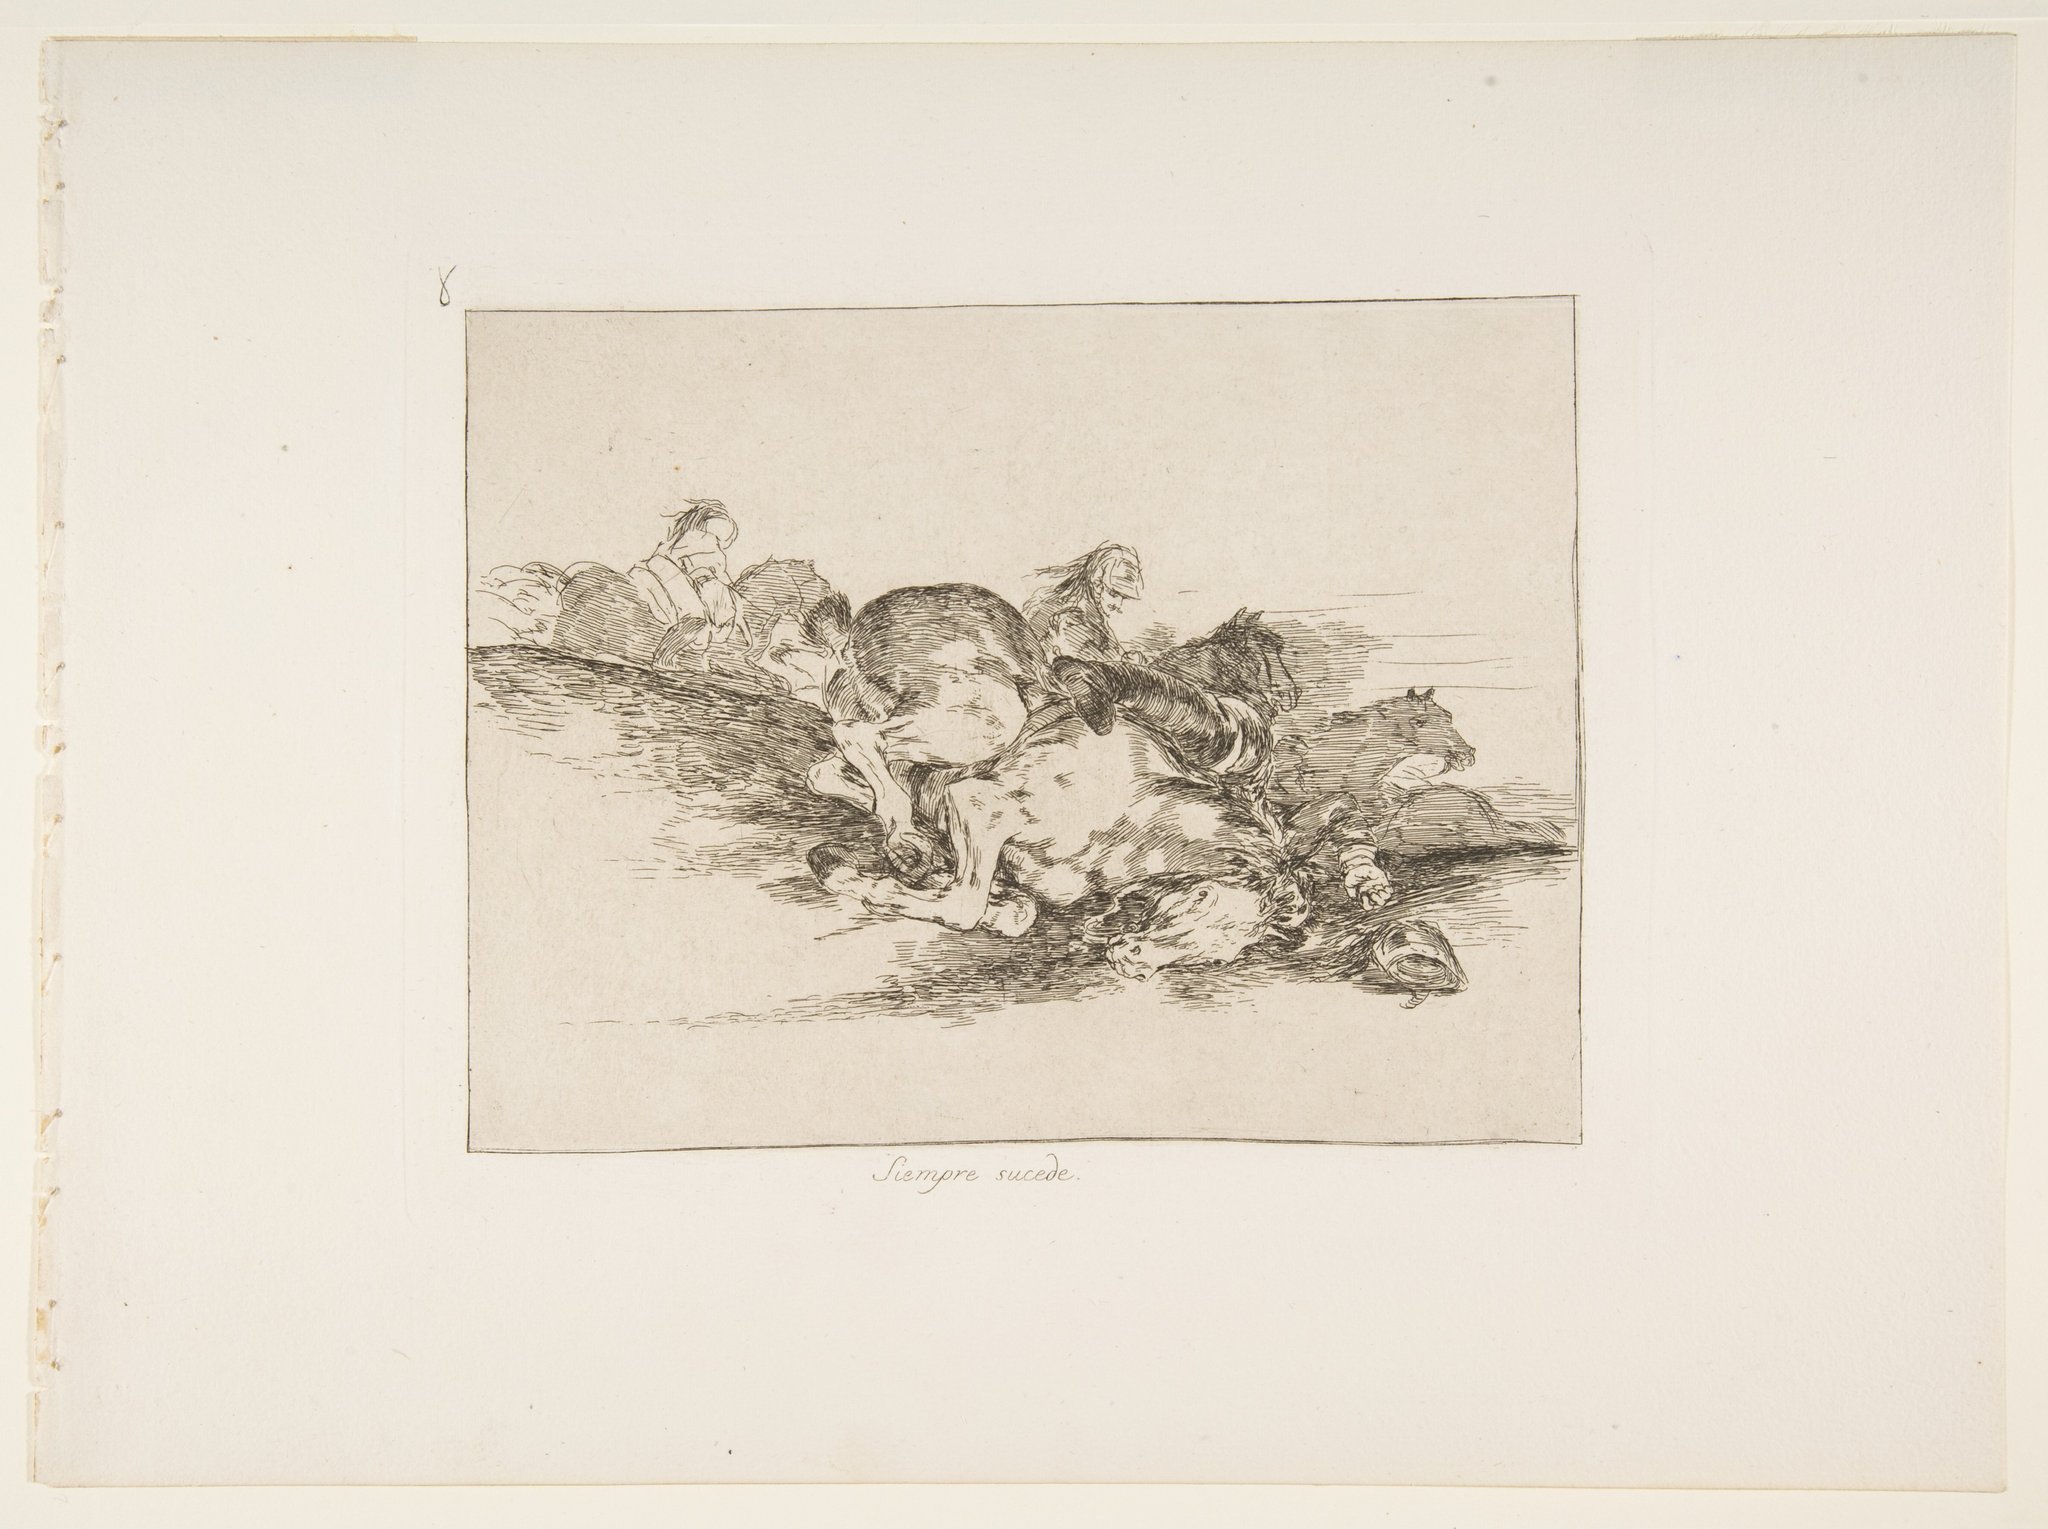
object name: print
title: Plate 8 from "The Disasters of War" (Los Desastres de la Guerra): 'It always happens' (Siempre sucede)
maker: goya (francisco de goya y lucientes)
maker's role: artist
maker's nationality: spanish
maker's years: 1746-1828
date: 1810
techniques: drypoint, etching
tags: human figures,horses,death